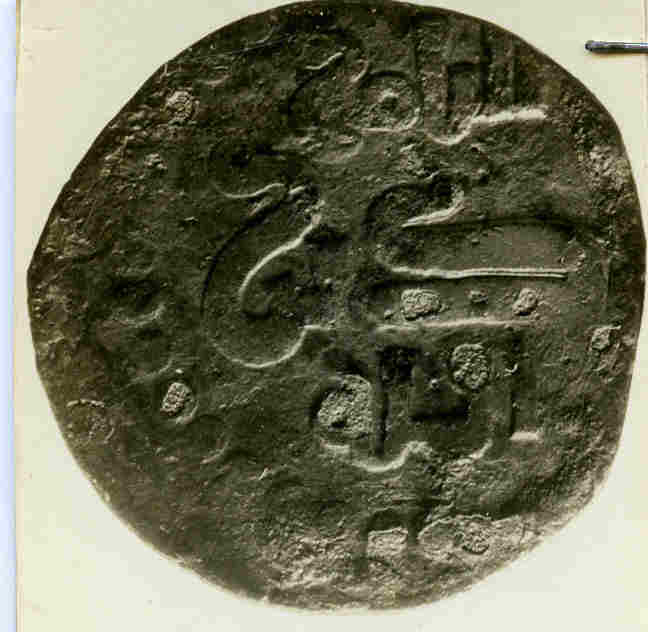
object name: coin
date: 1167-1233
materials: copper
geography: iran